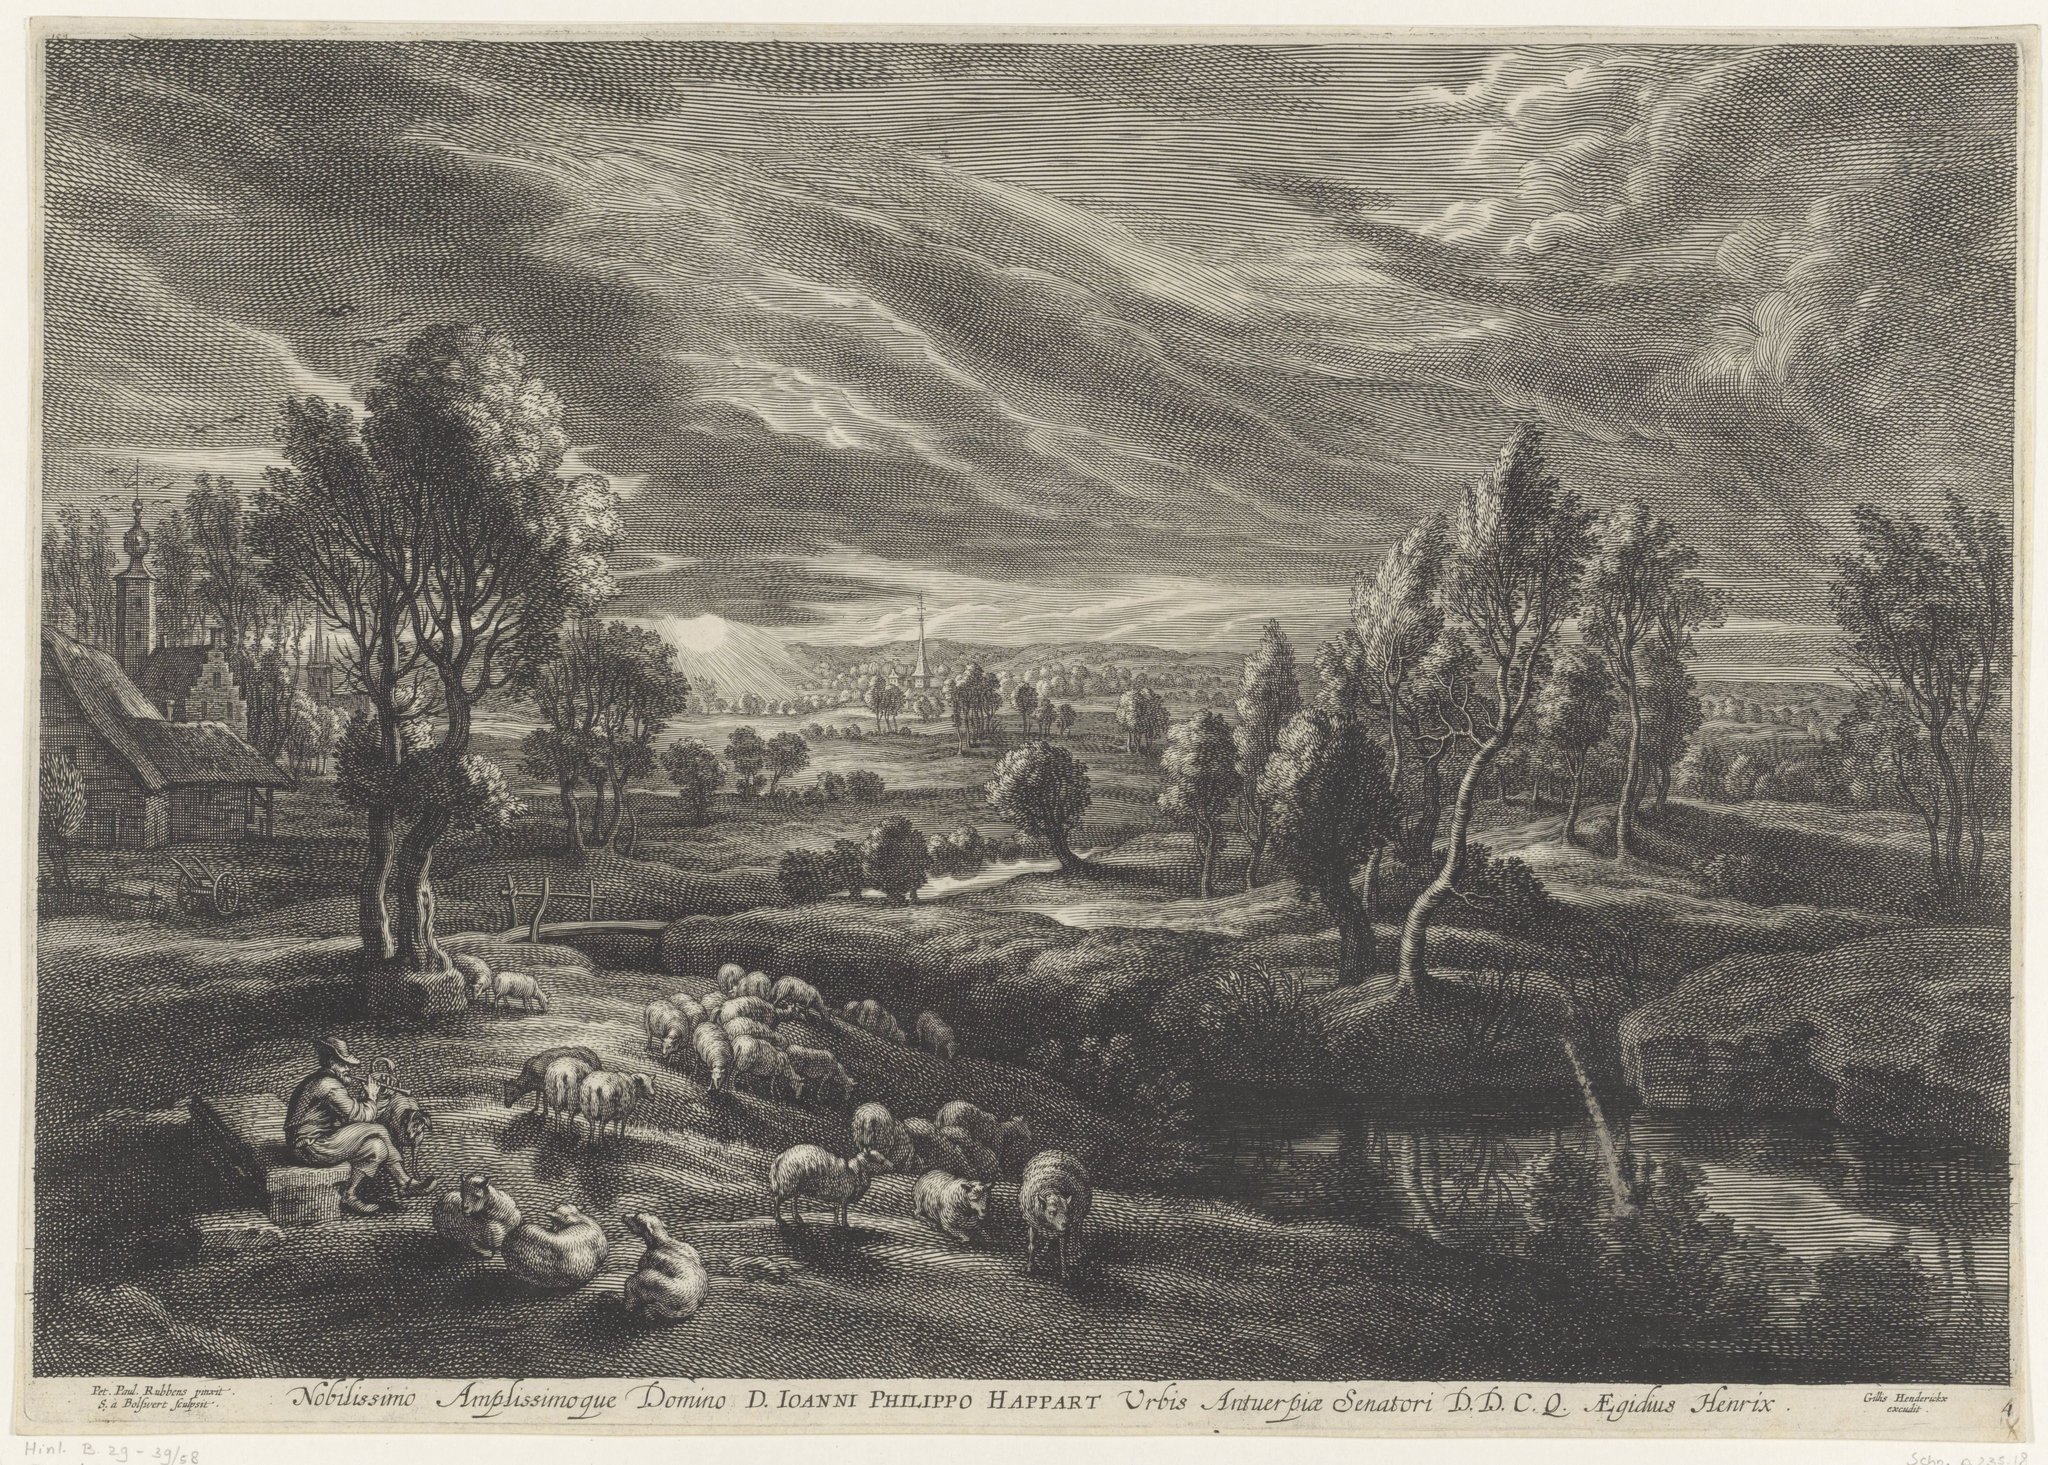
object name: print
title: Landschap met herder en kudde schapen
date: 1596-1659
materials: paper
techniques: engraving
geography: antwerp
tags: herding, herdsman, herdswoman, shepherd, shepherdess, cowherd, etc., sheep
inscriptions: inscription: ‘B 29 39-58’, collector's mark: Lugt 10, collector's mark: Lugt 11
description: Prent naar schilderij van Peter Paul Rubens. Hollstein beschrijft een serie kleine landschappen onder de nrs. 305 t/m 325 maar deze prenten zijn niet als reeks vervaardigd.